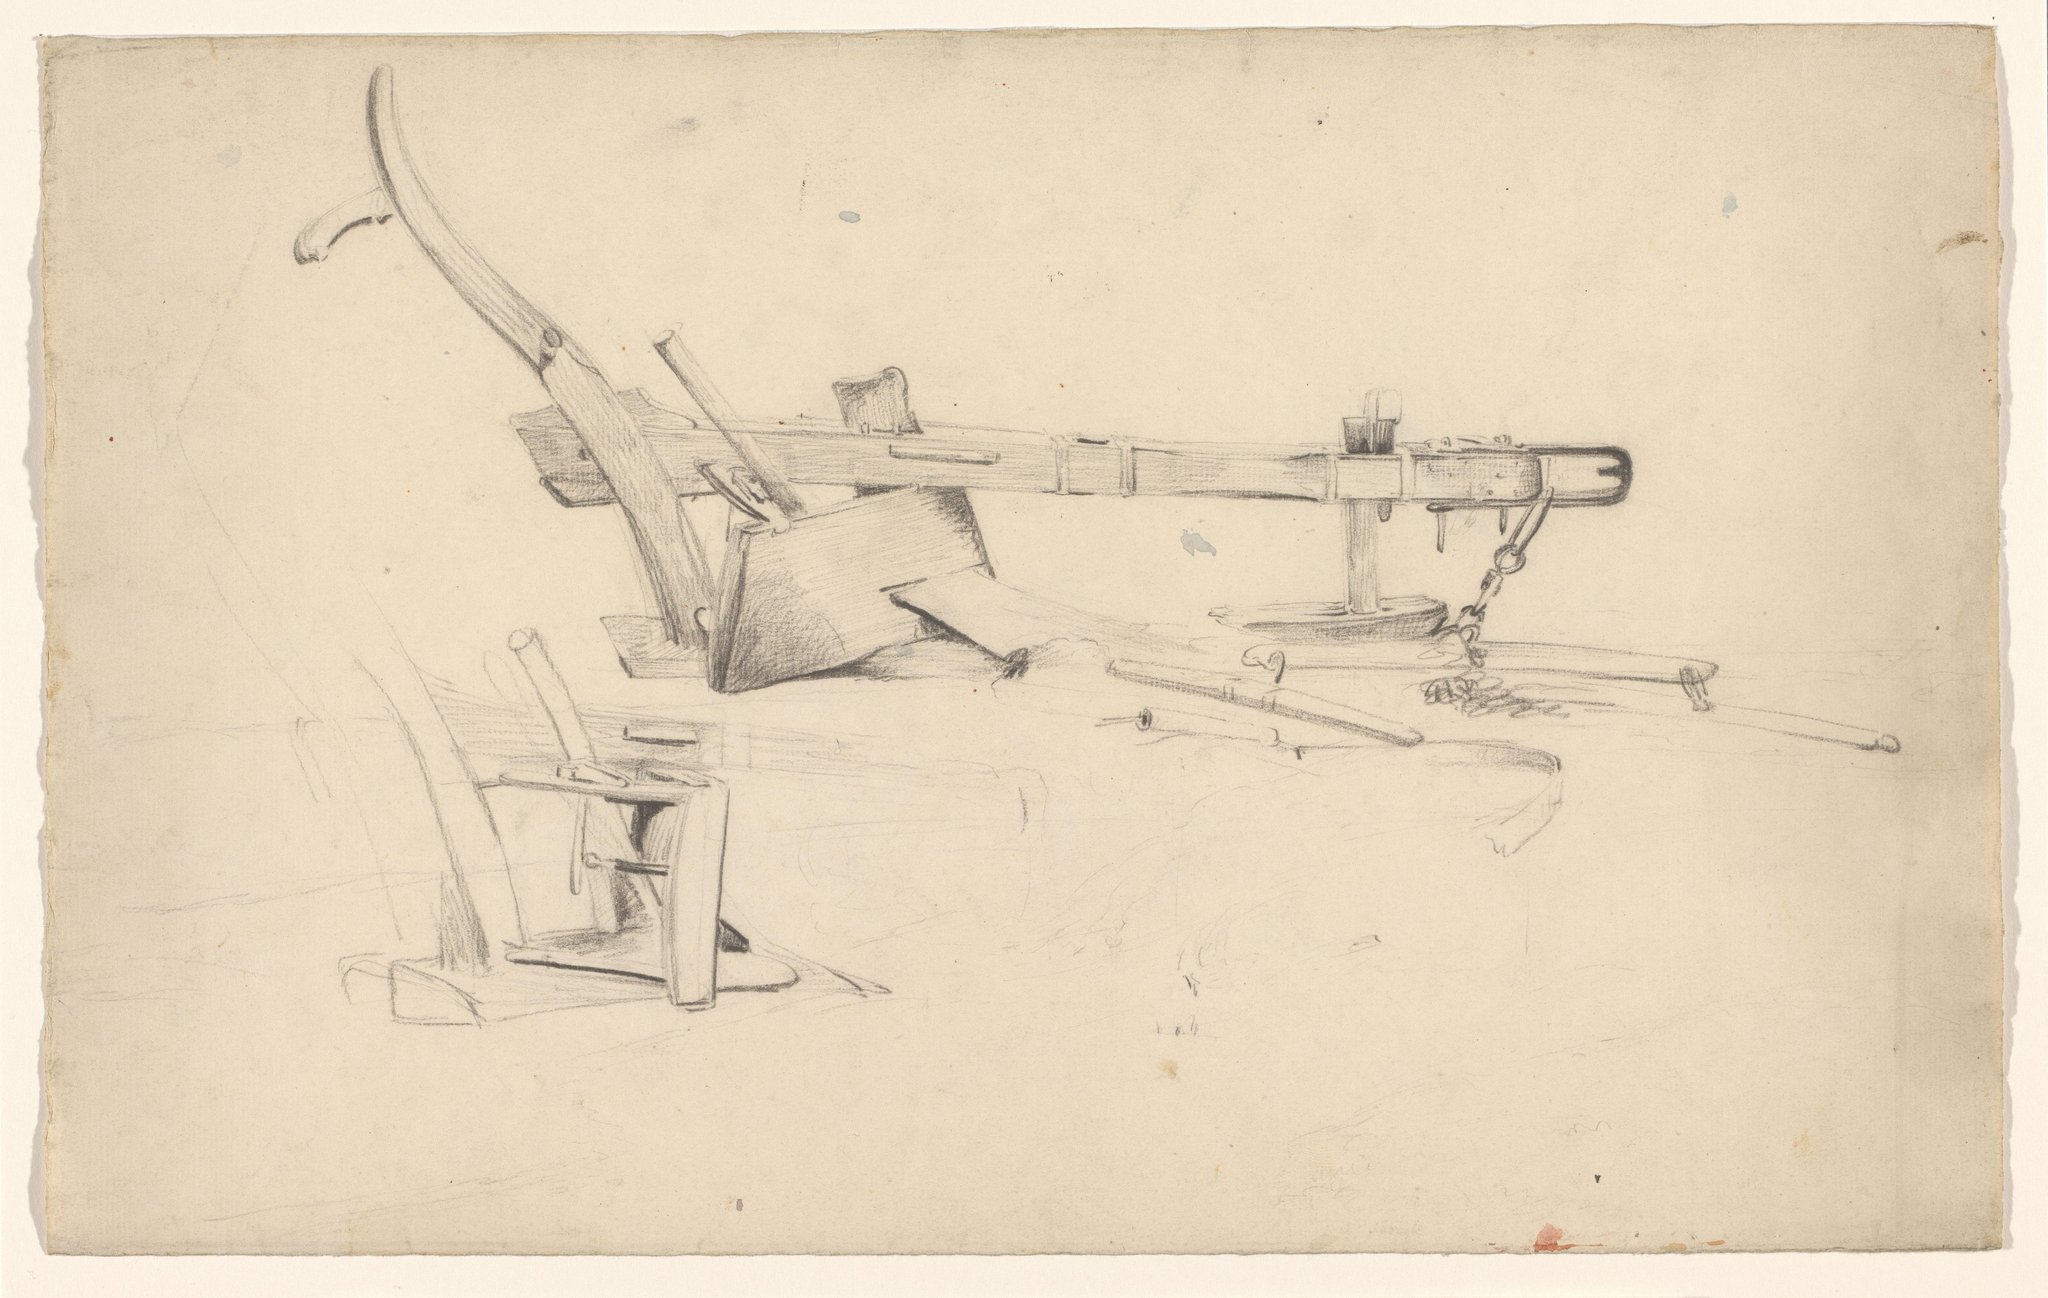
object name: drawing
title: Studies van een paardenploeg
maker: jan bedijs tom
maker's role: draughtsman, painter, print maker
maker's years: 1813-1894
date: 1823-1894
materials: chalk, paper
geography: the hague